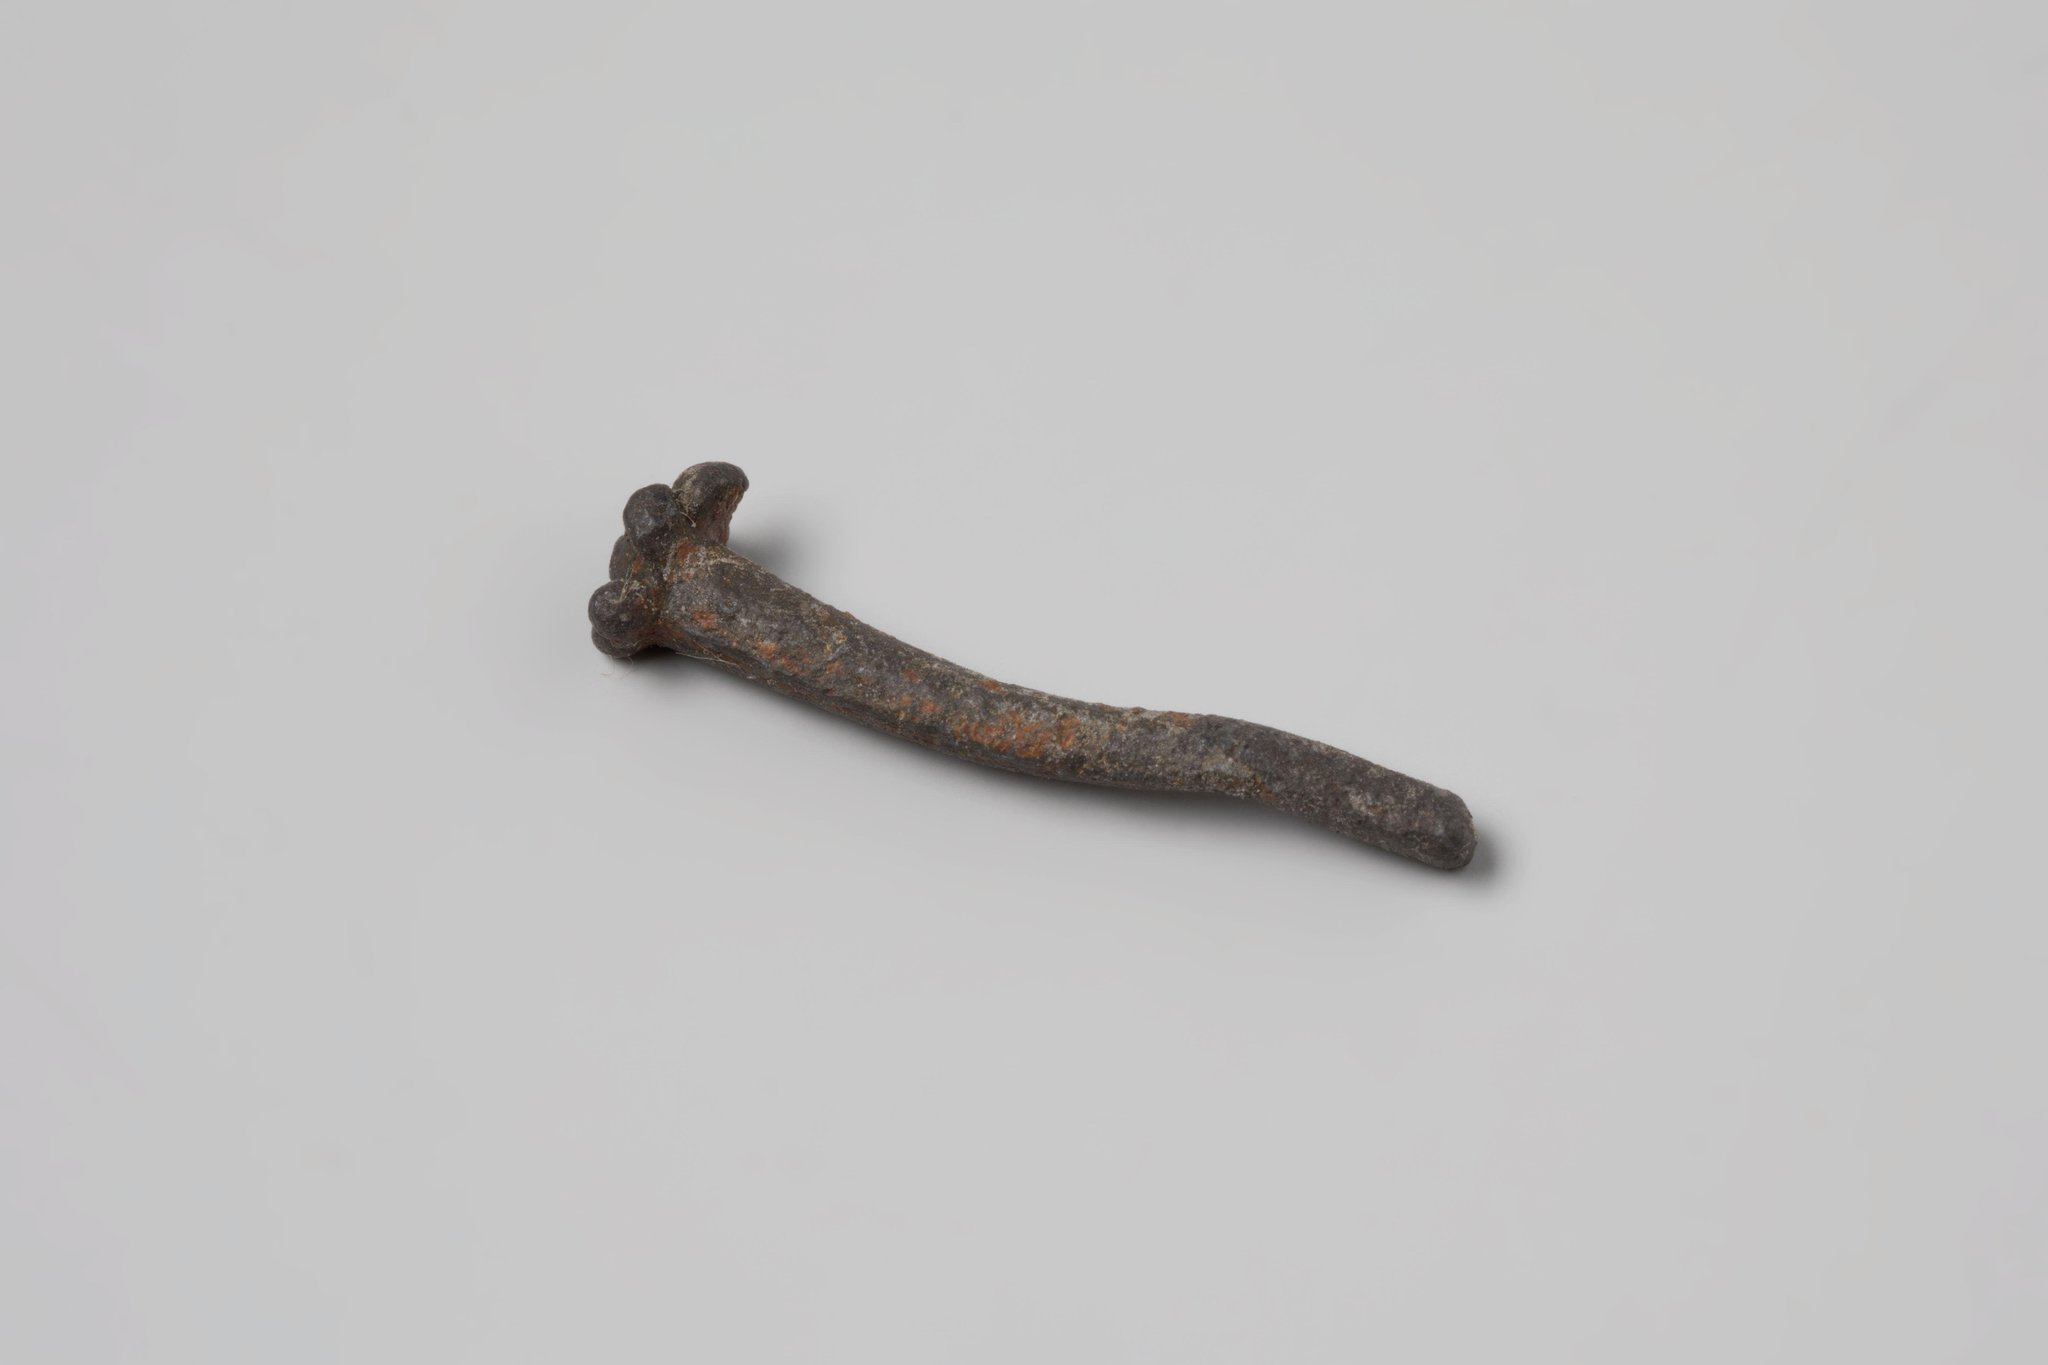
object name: beslag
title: Decoratief beslag uit het wrak van de Oost-Indiëvaarder Hollandia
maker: Anonymous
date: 1700-1743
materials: tin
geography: netherlands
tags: verenigde oostindische compagnie, hollandia (schip), annet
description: Fitting, decorative fitting or fragment; tapering peg with flower-head on upper end.